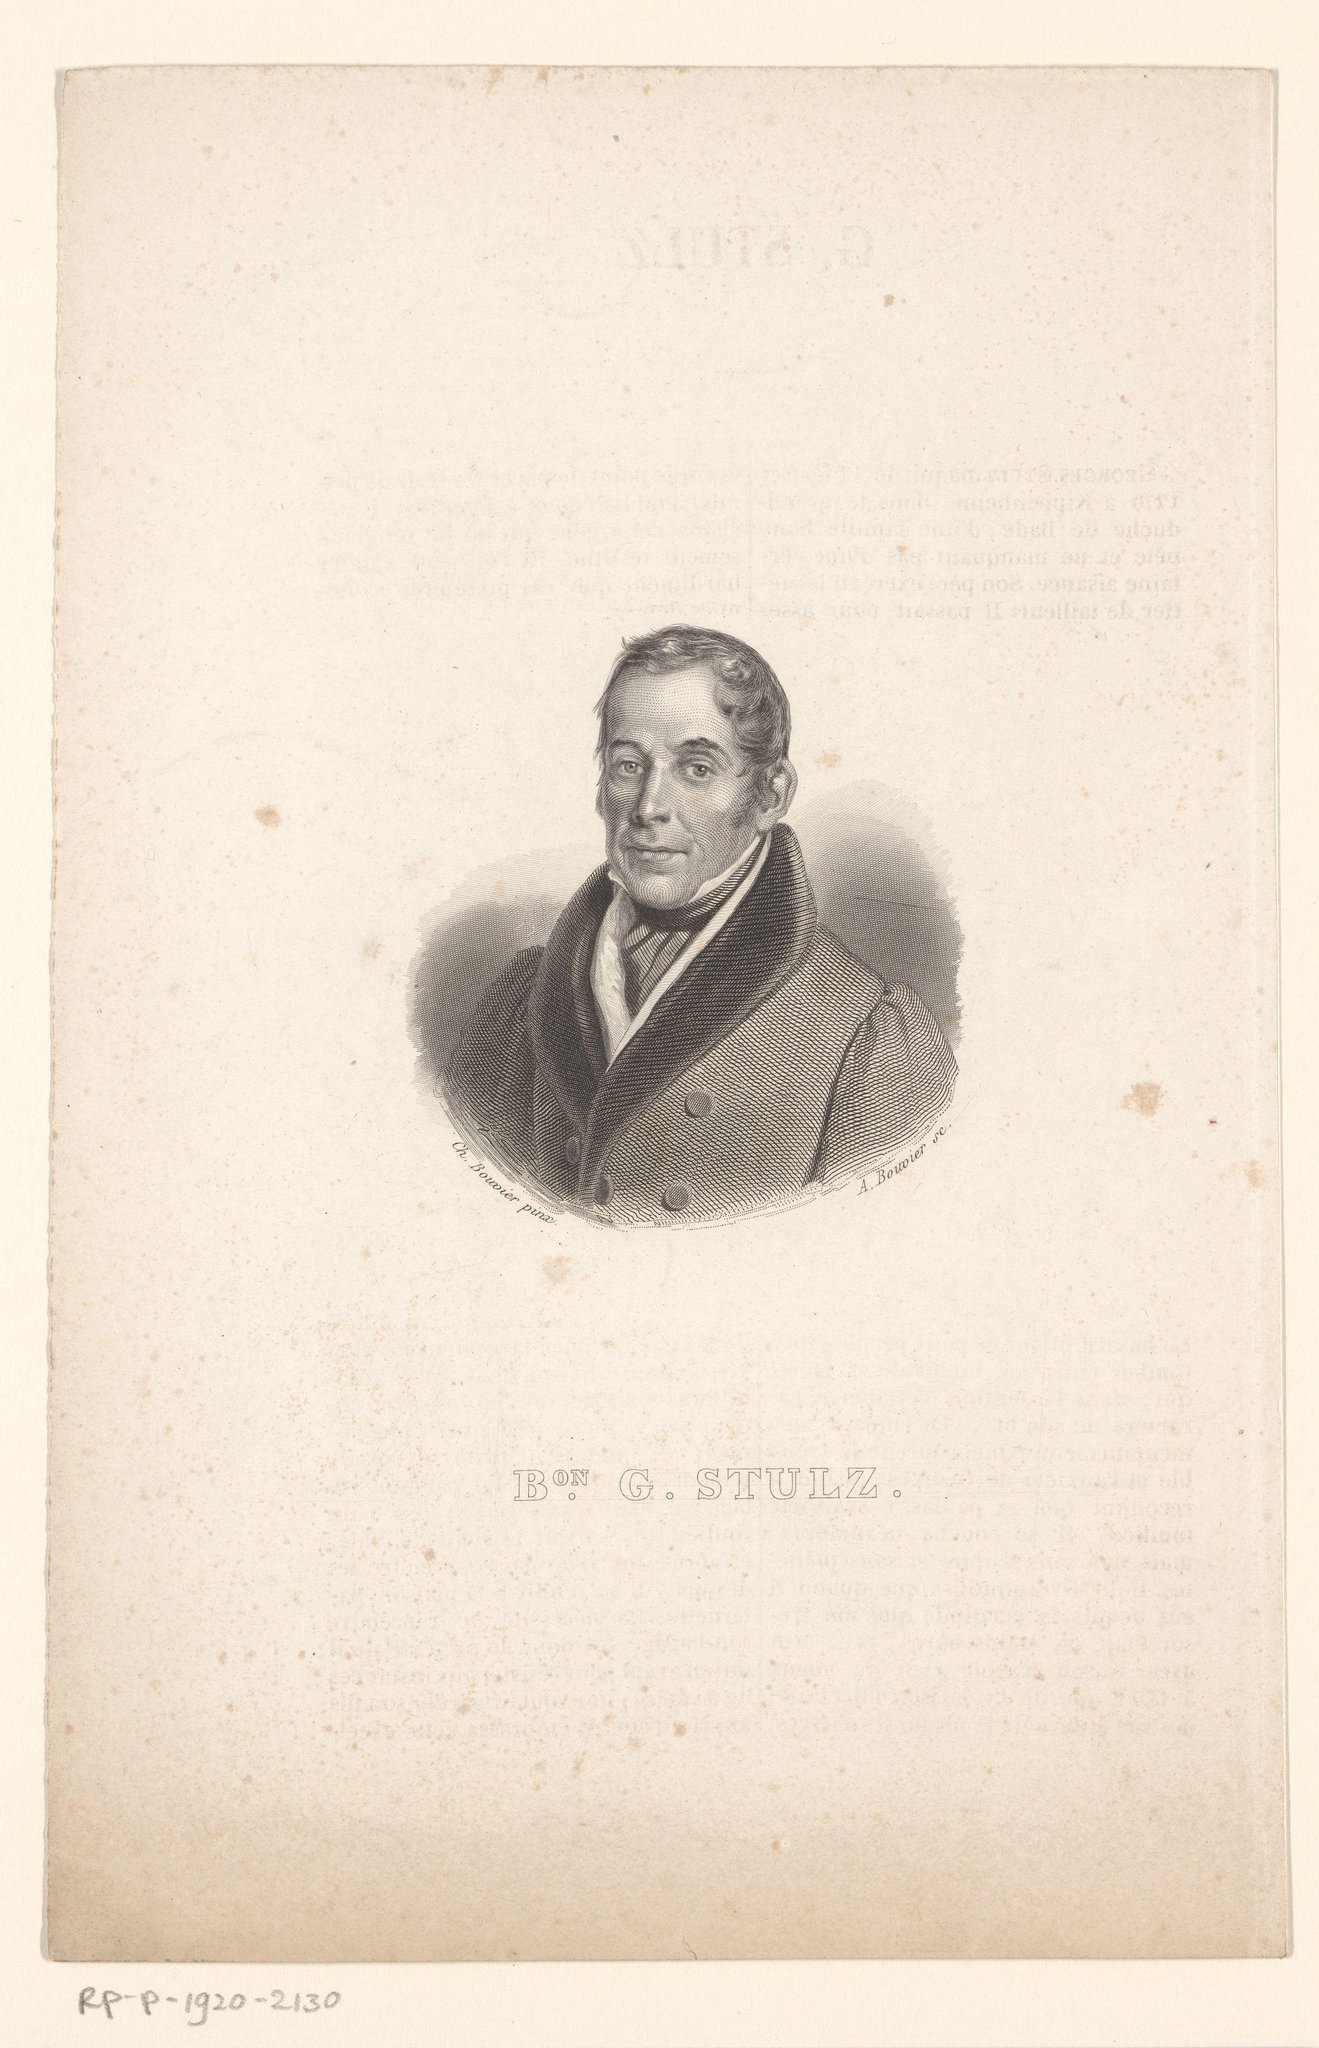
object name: print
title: B.on G. Stulz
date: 1811-1872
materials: paper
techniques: engraving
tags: adult man, historical persons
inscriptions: collector's mark: Lugt 2228